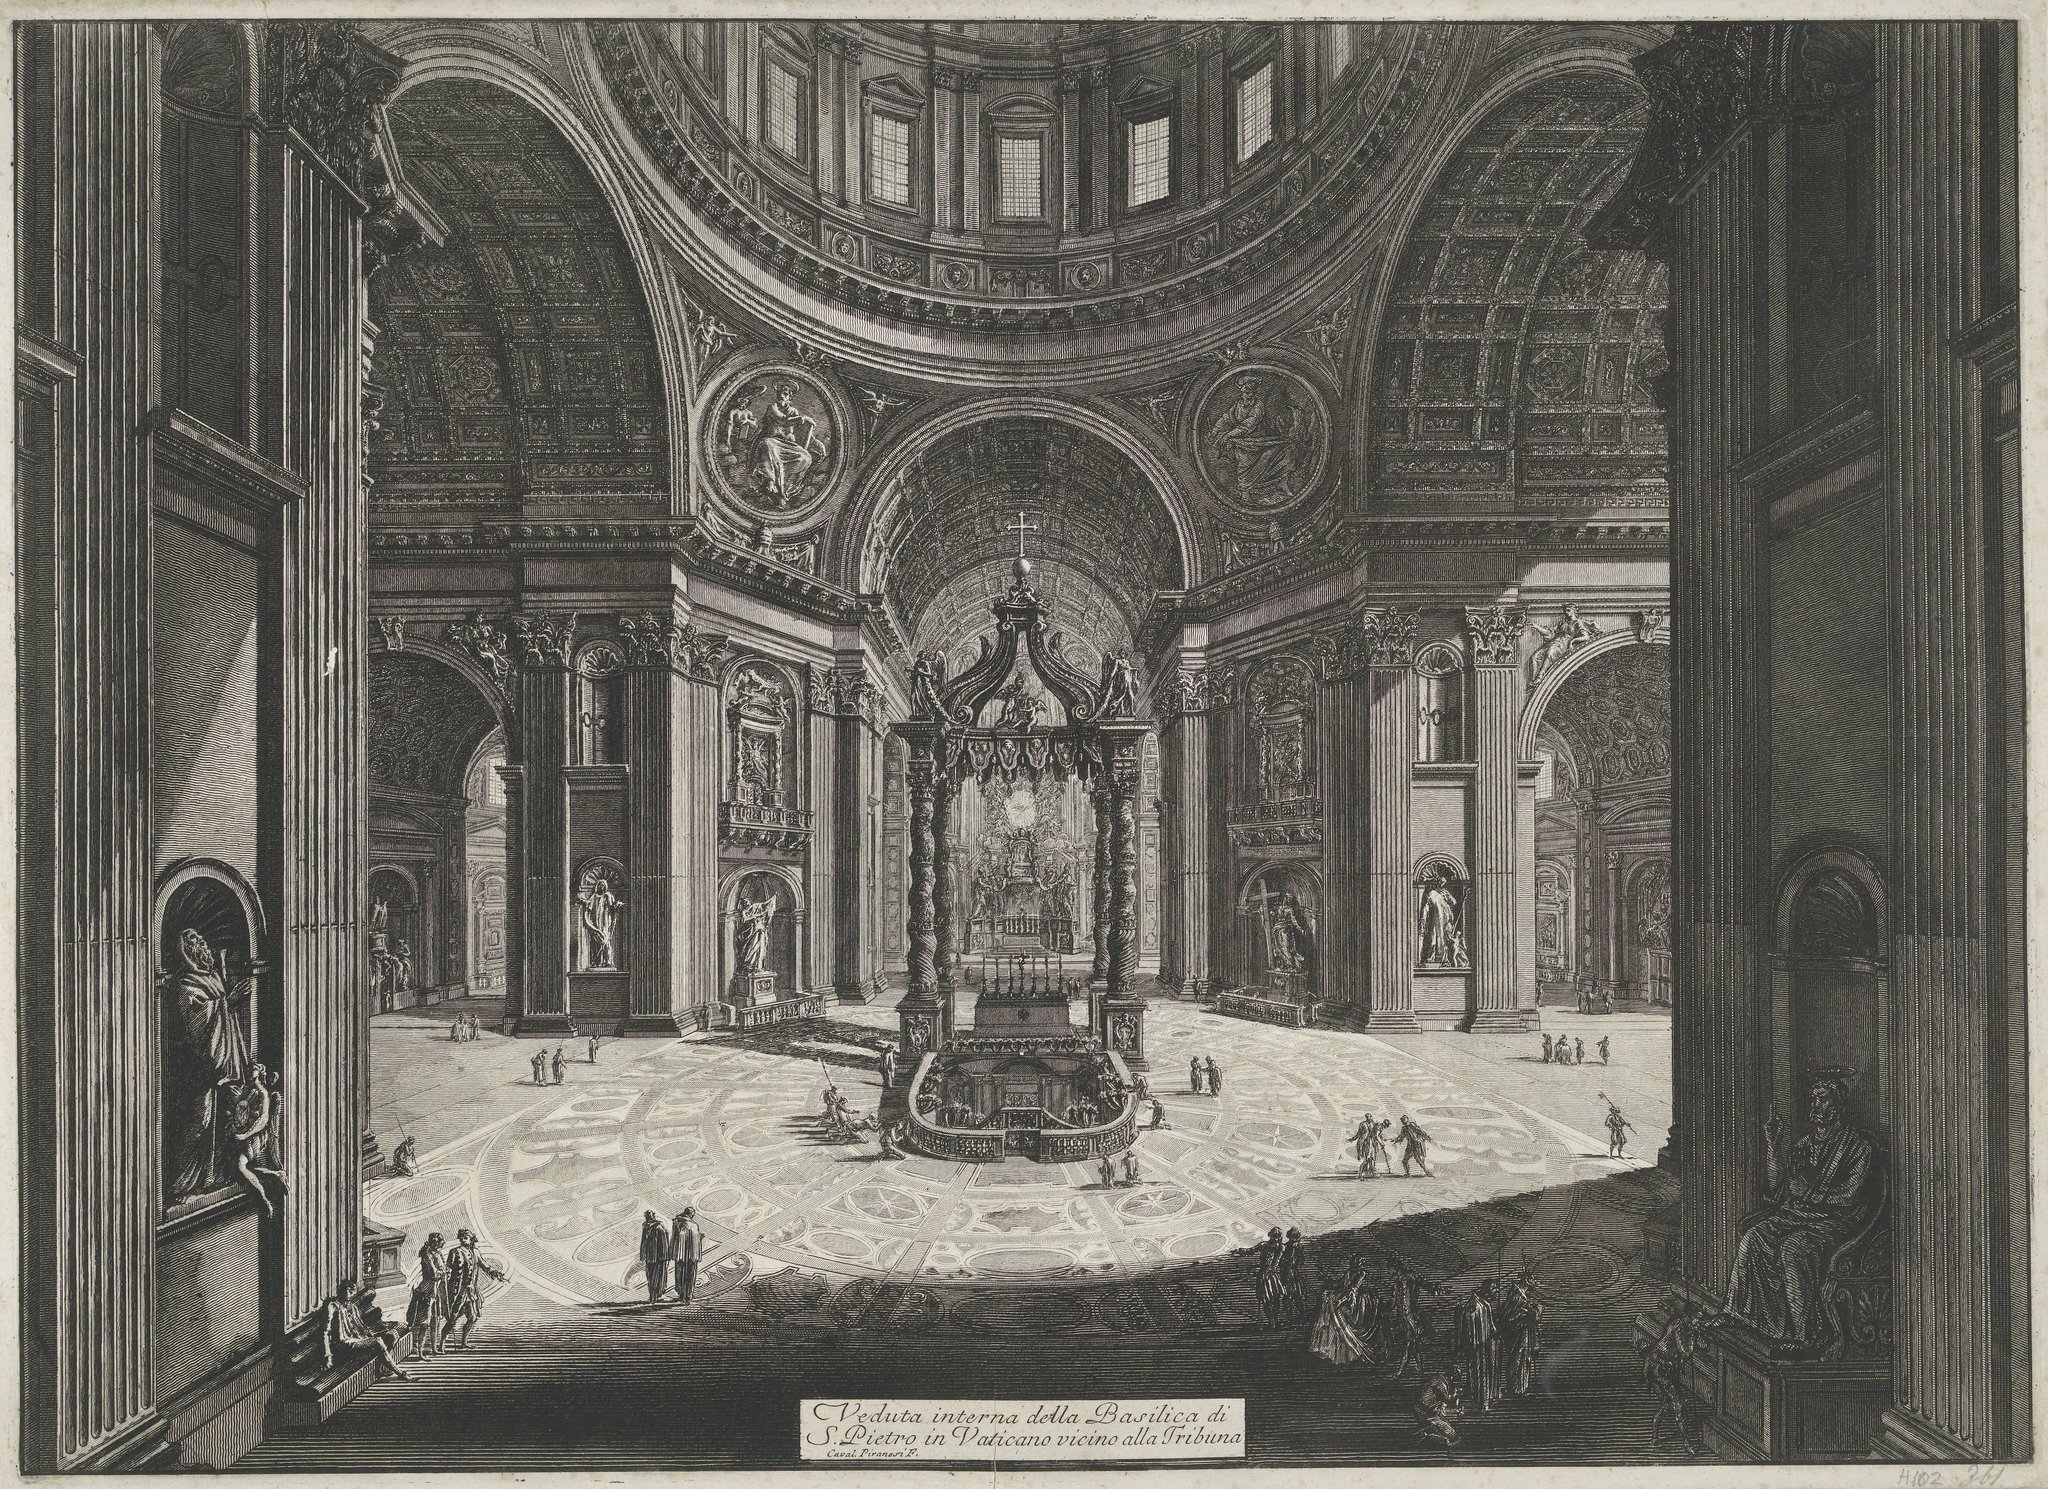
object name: print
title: Vedute di Roma disegnate ed incise da Giambattista Piranesi architetto Ve(nez)iano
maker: giovanni battista piranesi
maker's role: designer, draughtsman, print maker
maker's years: 1720-1778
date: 1748-1778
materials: paper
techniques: etching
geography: rome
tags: parts of church interior: transept, roman catholic church, interior of church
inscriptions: collector's mark: Lugt 2228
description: Deze prent maakt deel uit van de serie 'Vedute di Roma'. Piranesi werkte aan deze 135 platen tellende serie tussen 1748 en zijn dood in 1778. Francesco Piranesi voegde later nog twee prenten toe aan de reeks van zijn vader.